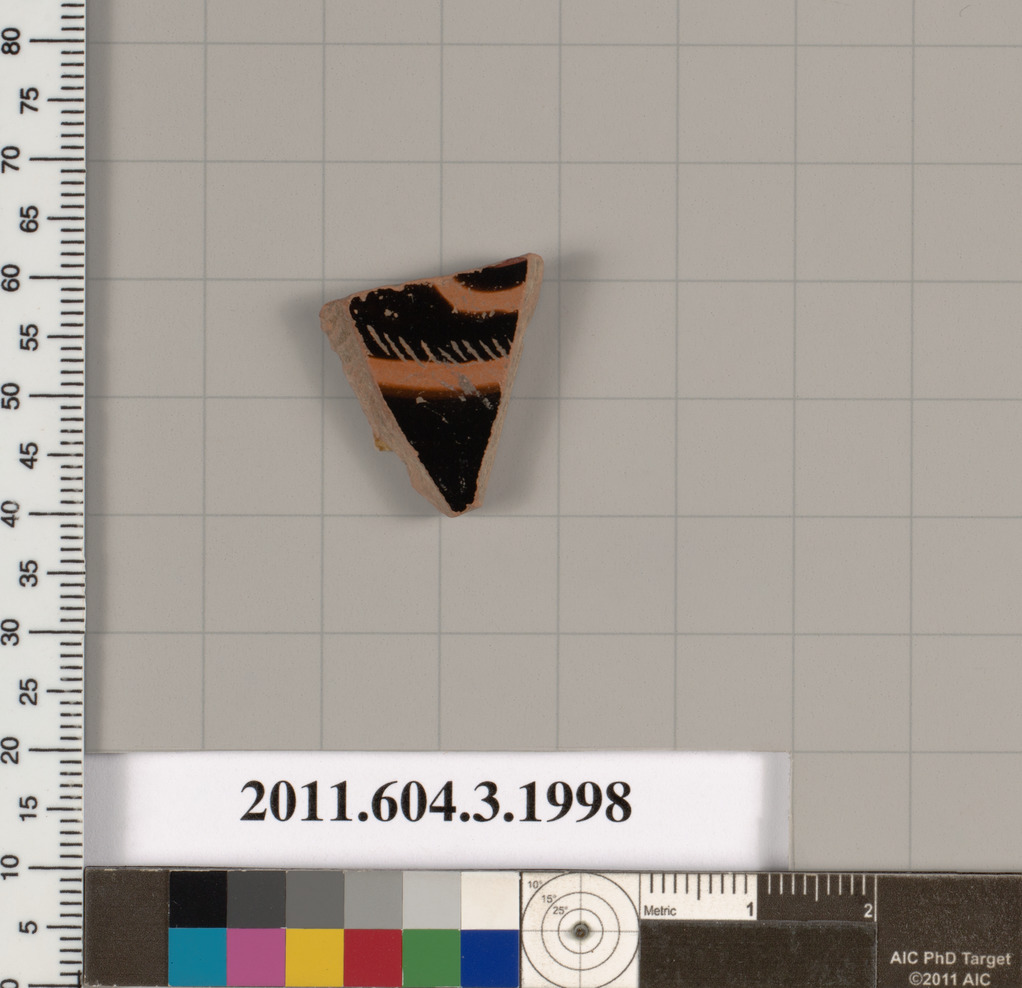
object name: kylix fragment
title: Terracotta fragment of a kylix (drinking cup)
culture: greek, attic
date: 550-526 BCE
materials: terracotta